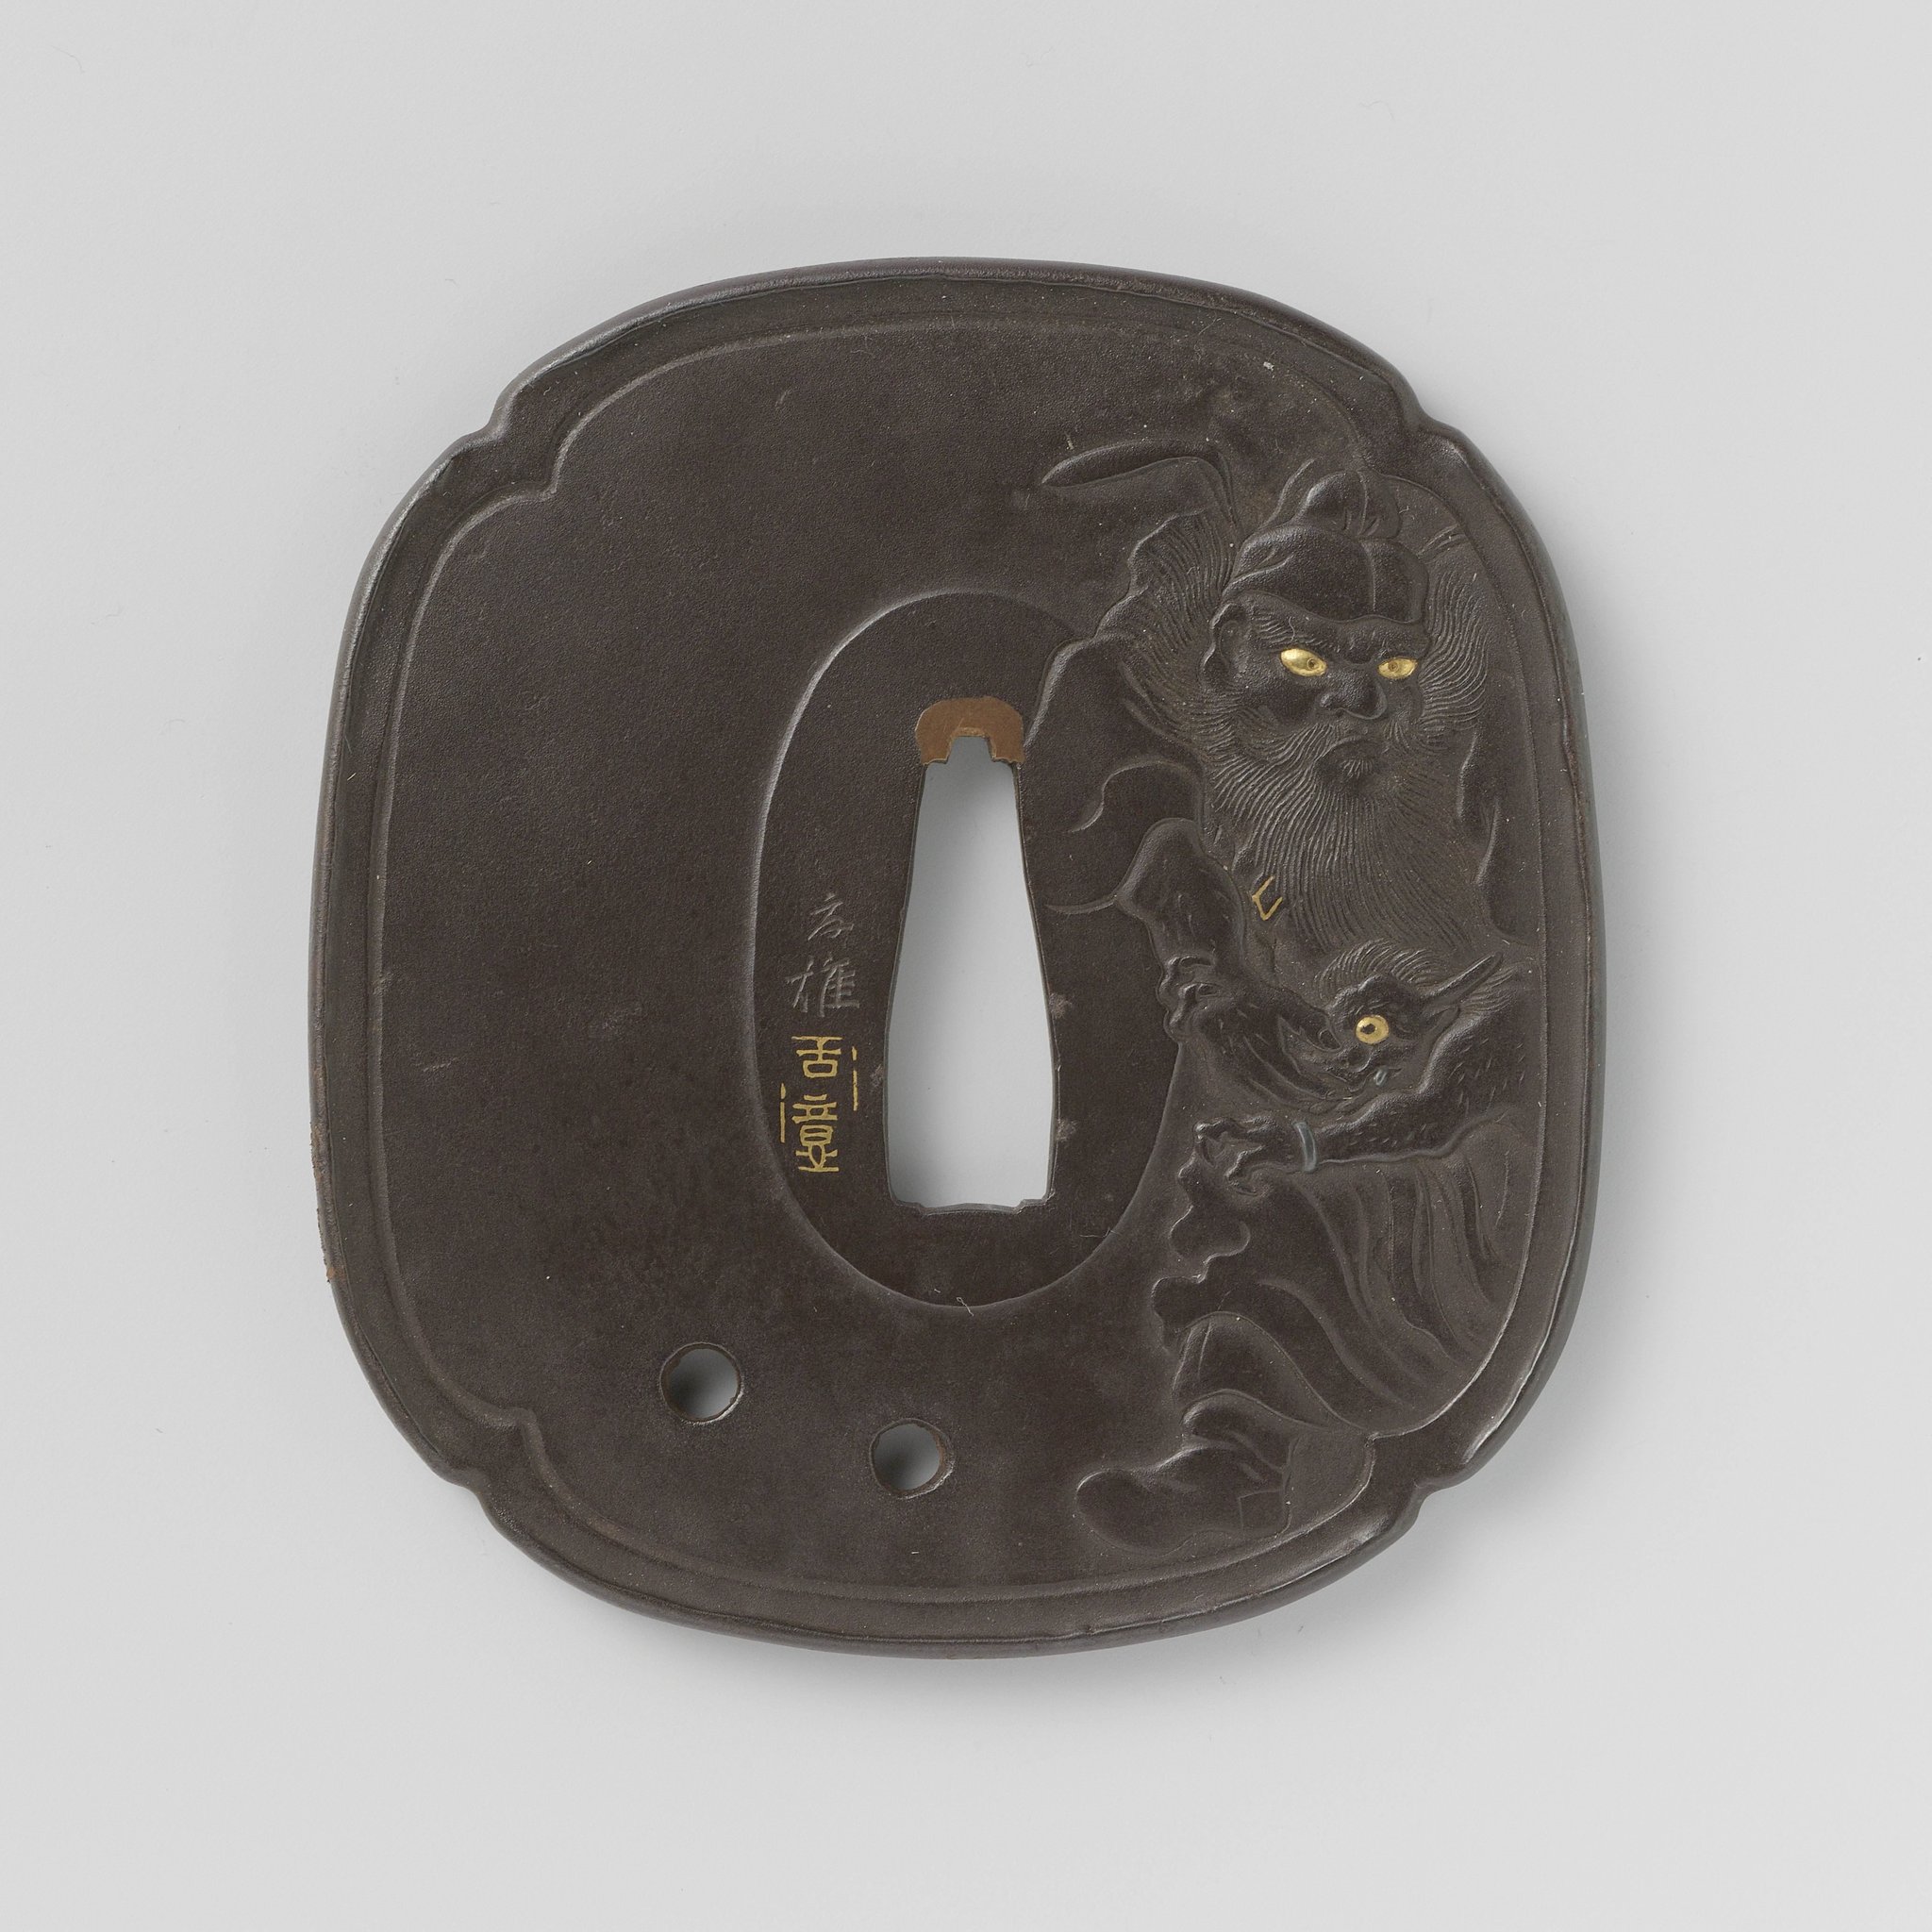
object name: tsuba, zwaardstootplaat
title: Hand guard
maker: natsuo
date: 1850-1875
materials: gold, iron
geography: japan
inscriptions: seal: ‘koi’, signature: ‘Natsuo’